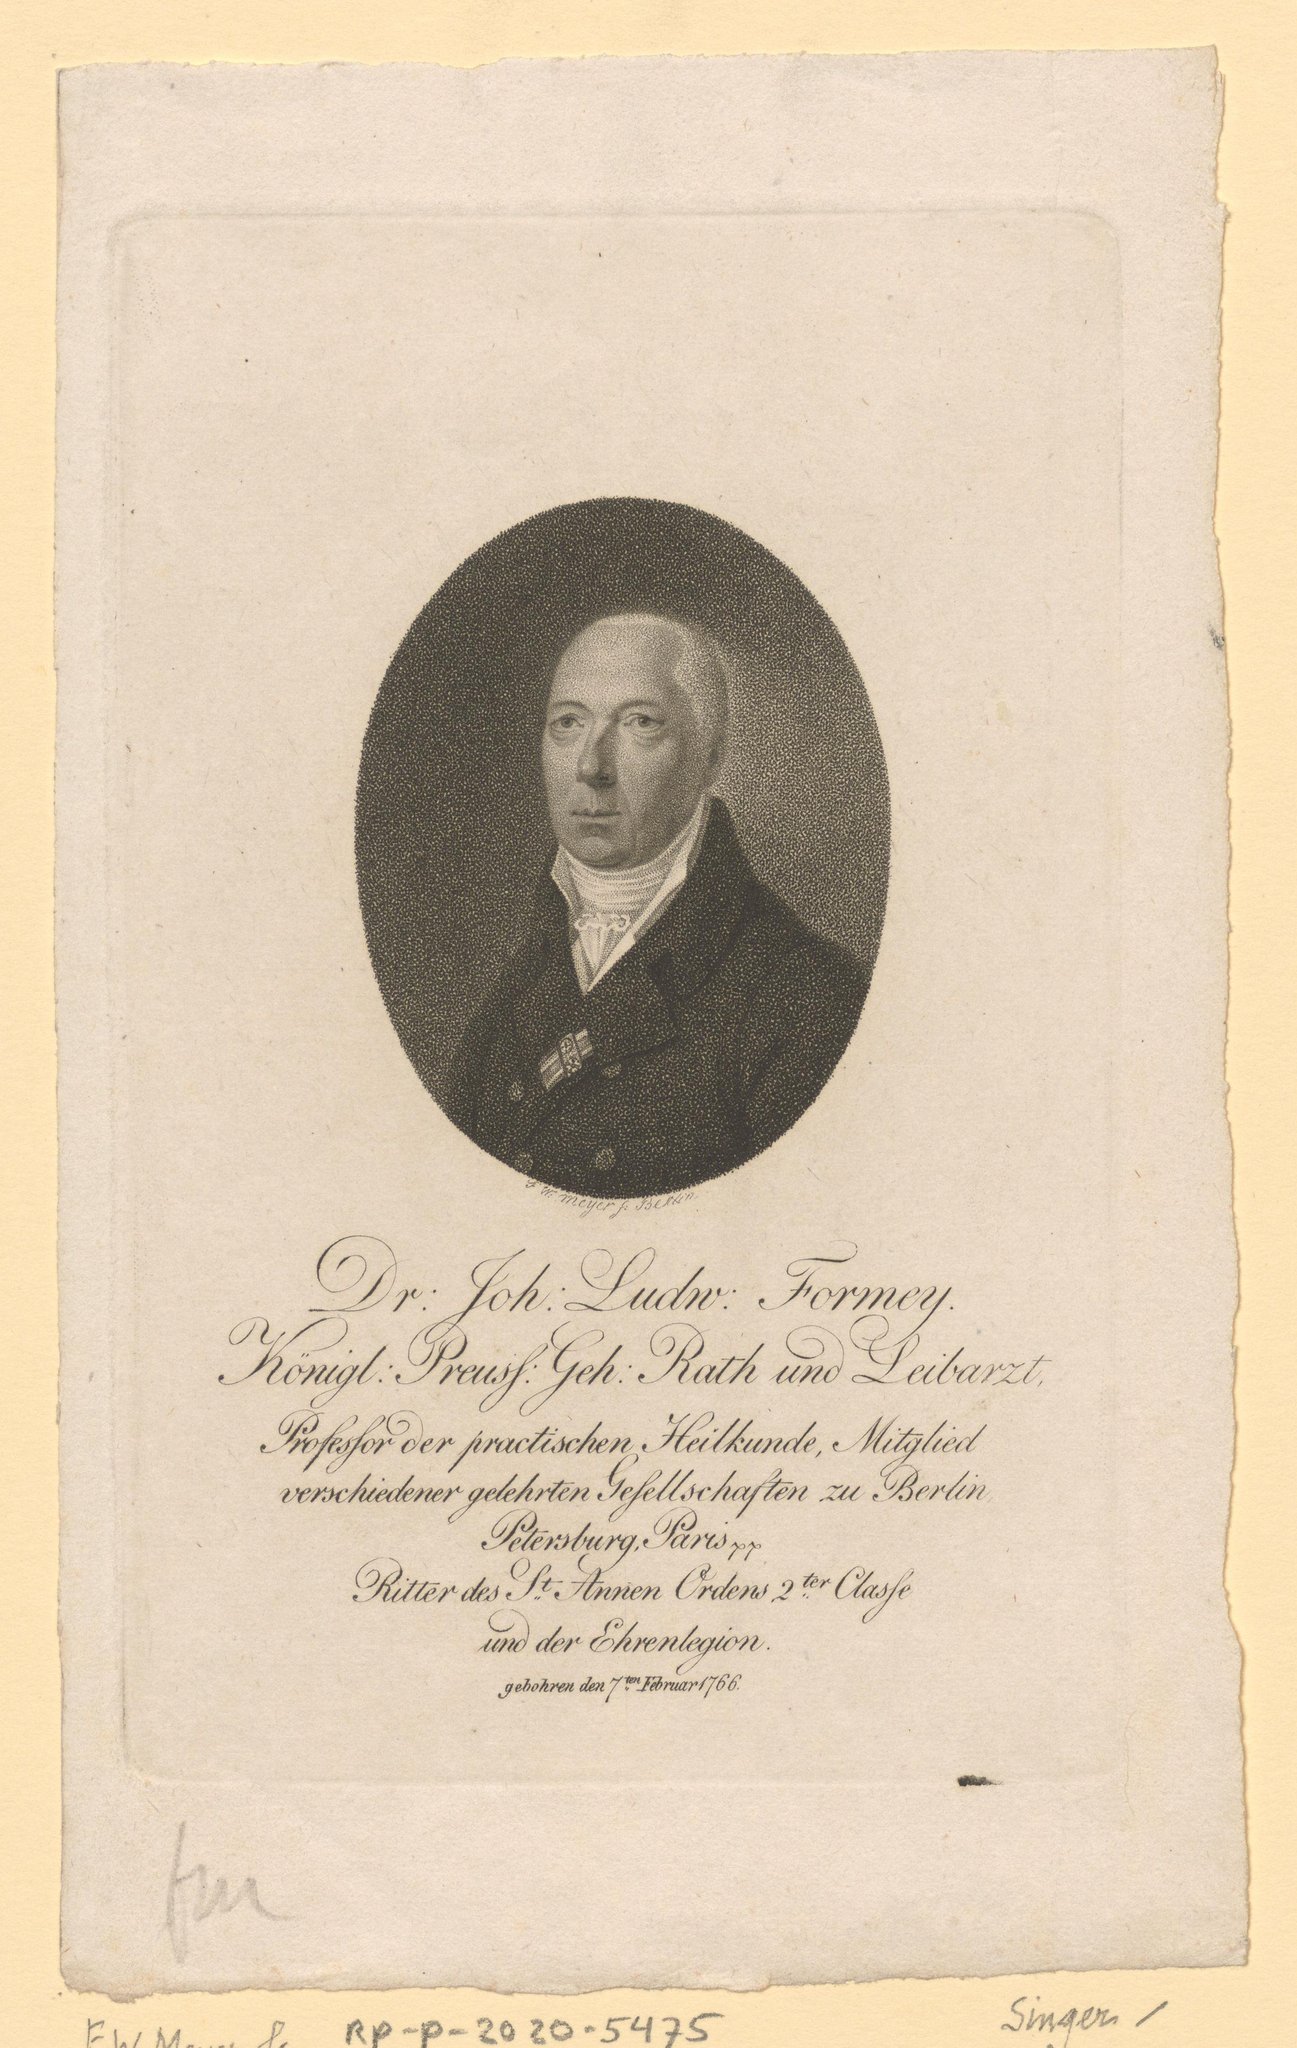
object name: print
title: Portret van Johann Ludwig Formey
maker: friedrich wilhelm meyer (i)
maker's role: print maker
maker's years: 1760-1880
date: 1800-1823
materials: paper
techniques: stippling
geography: berlin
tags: berlin, historical persons, physician, doctor (+ portrait of scholar, scientist)